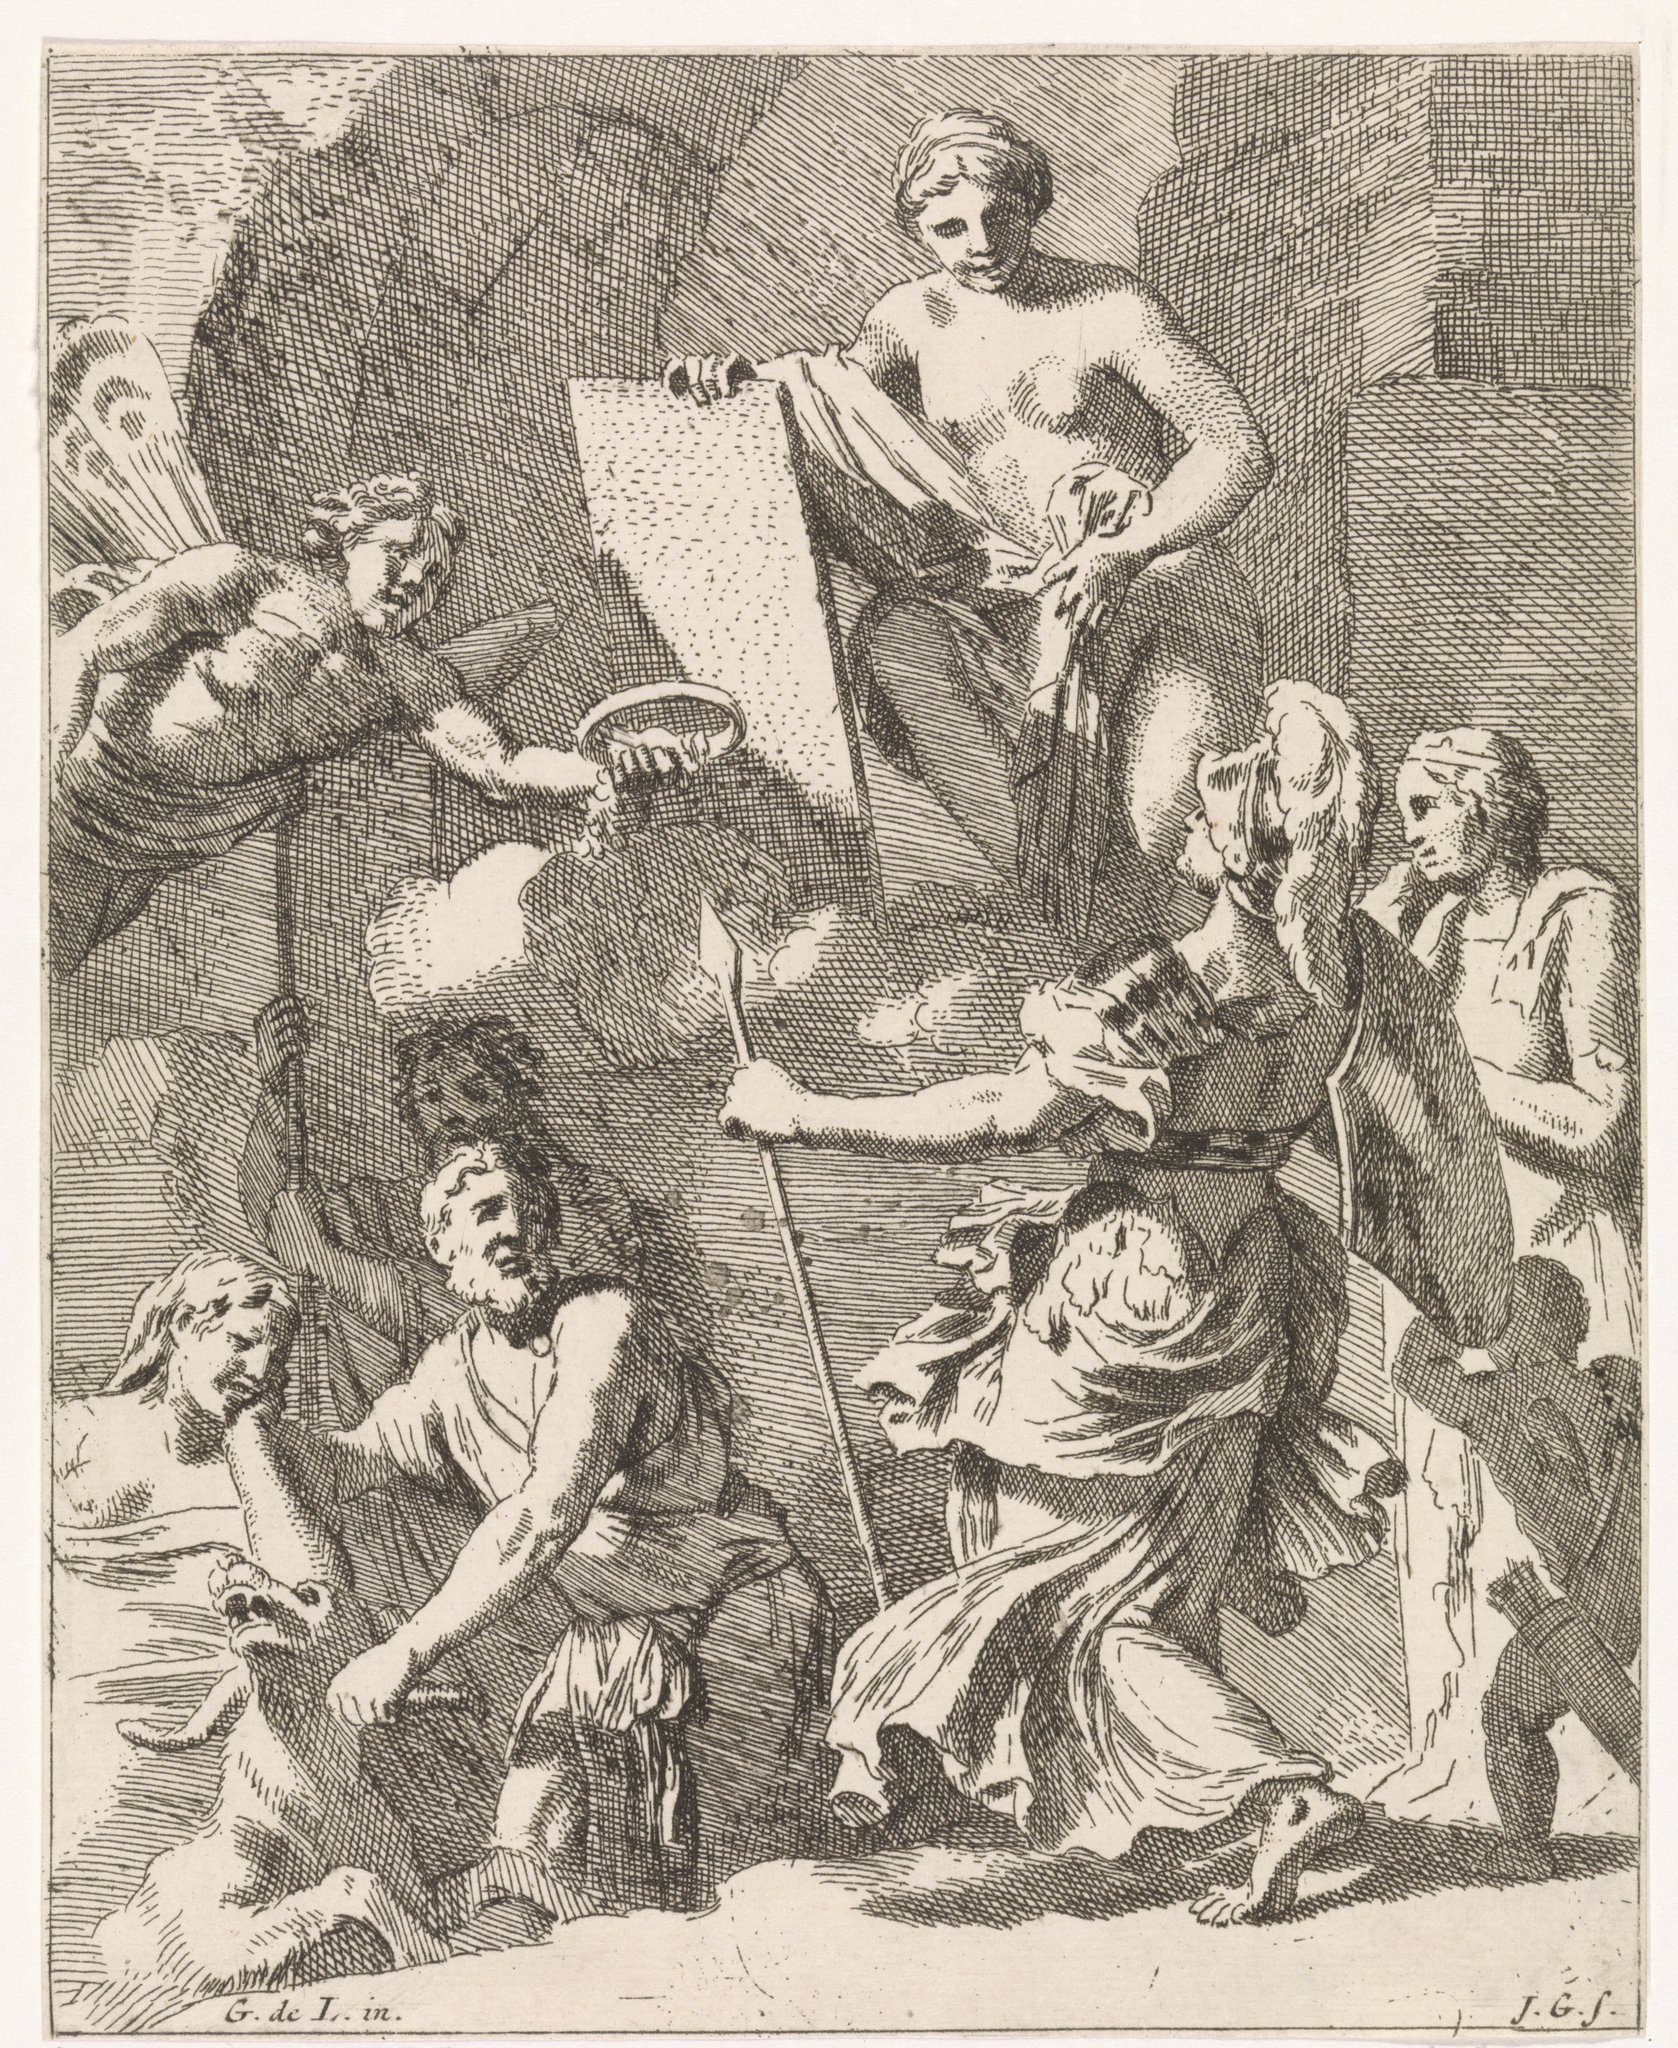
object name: print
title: Allegorie op de prentkunst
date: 1656-1726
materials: paper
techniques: etching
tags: (story of) minerva (pallas, athena), symbolic representations, allegories and emblems ~ the graphic arts, fame; 'fama', 'fama buona', 'fama chiara' (ripa)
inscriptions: collector's mark: Lugt 240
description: De vliegende Faam (Fama) reikt Minerva een erekroon aan. Op de achtergrond de personificatie van prentkunst, een vrouw met een grote metalen plakkaat in haar handen. De prent maakt deel uit van een serie met mythologische en allegorische voorstellingen.